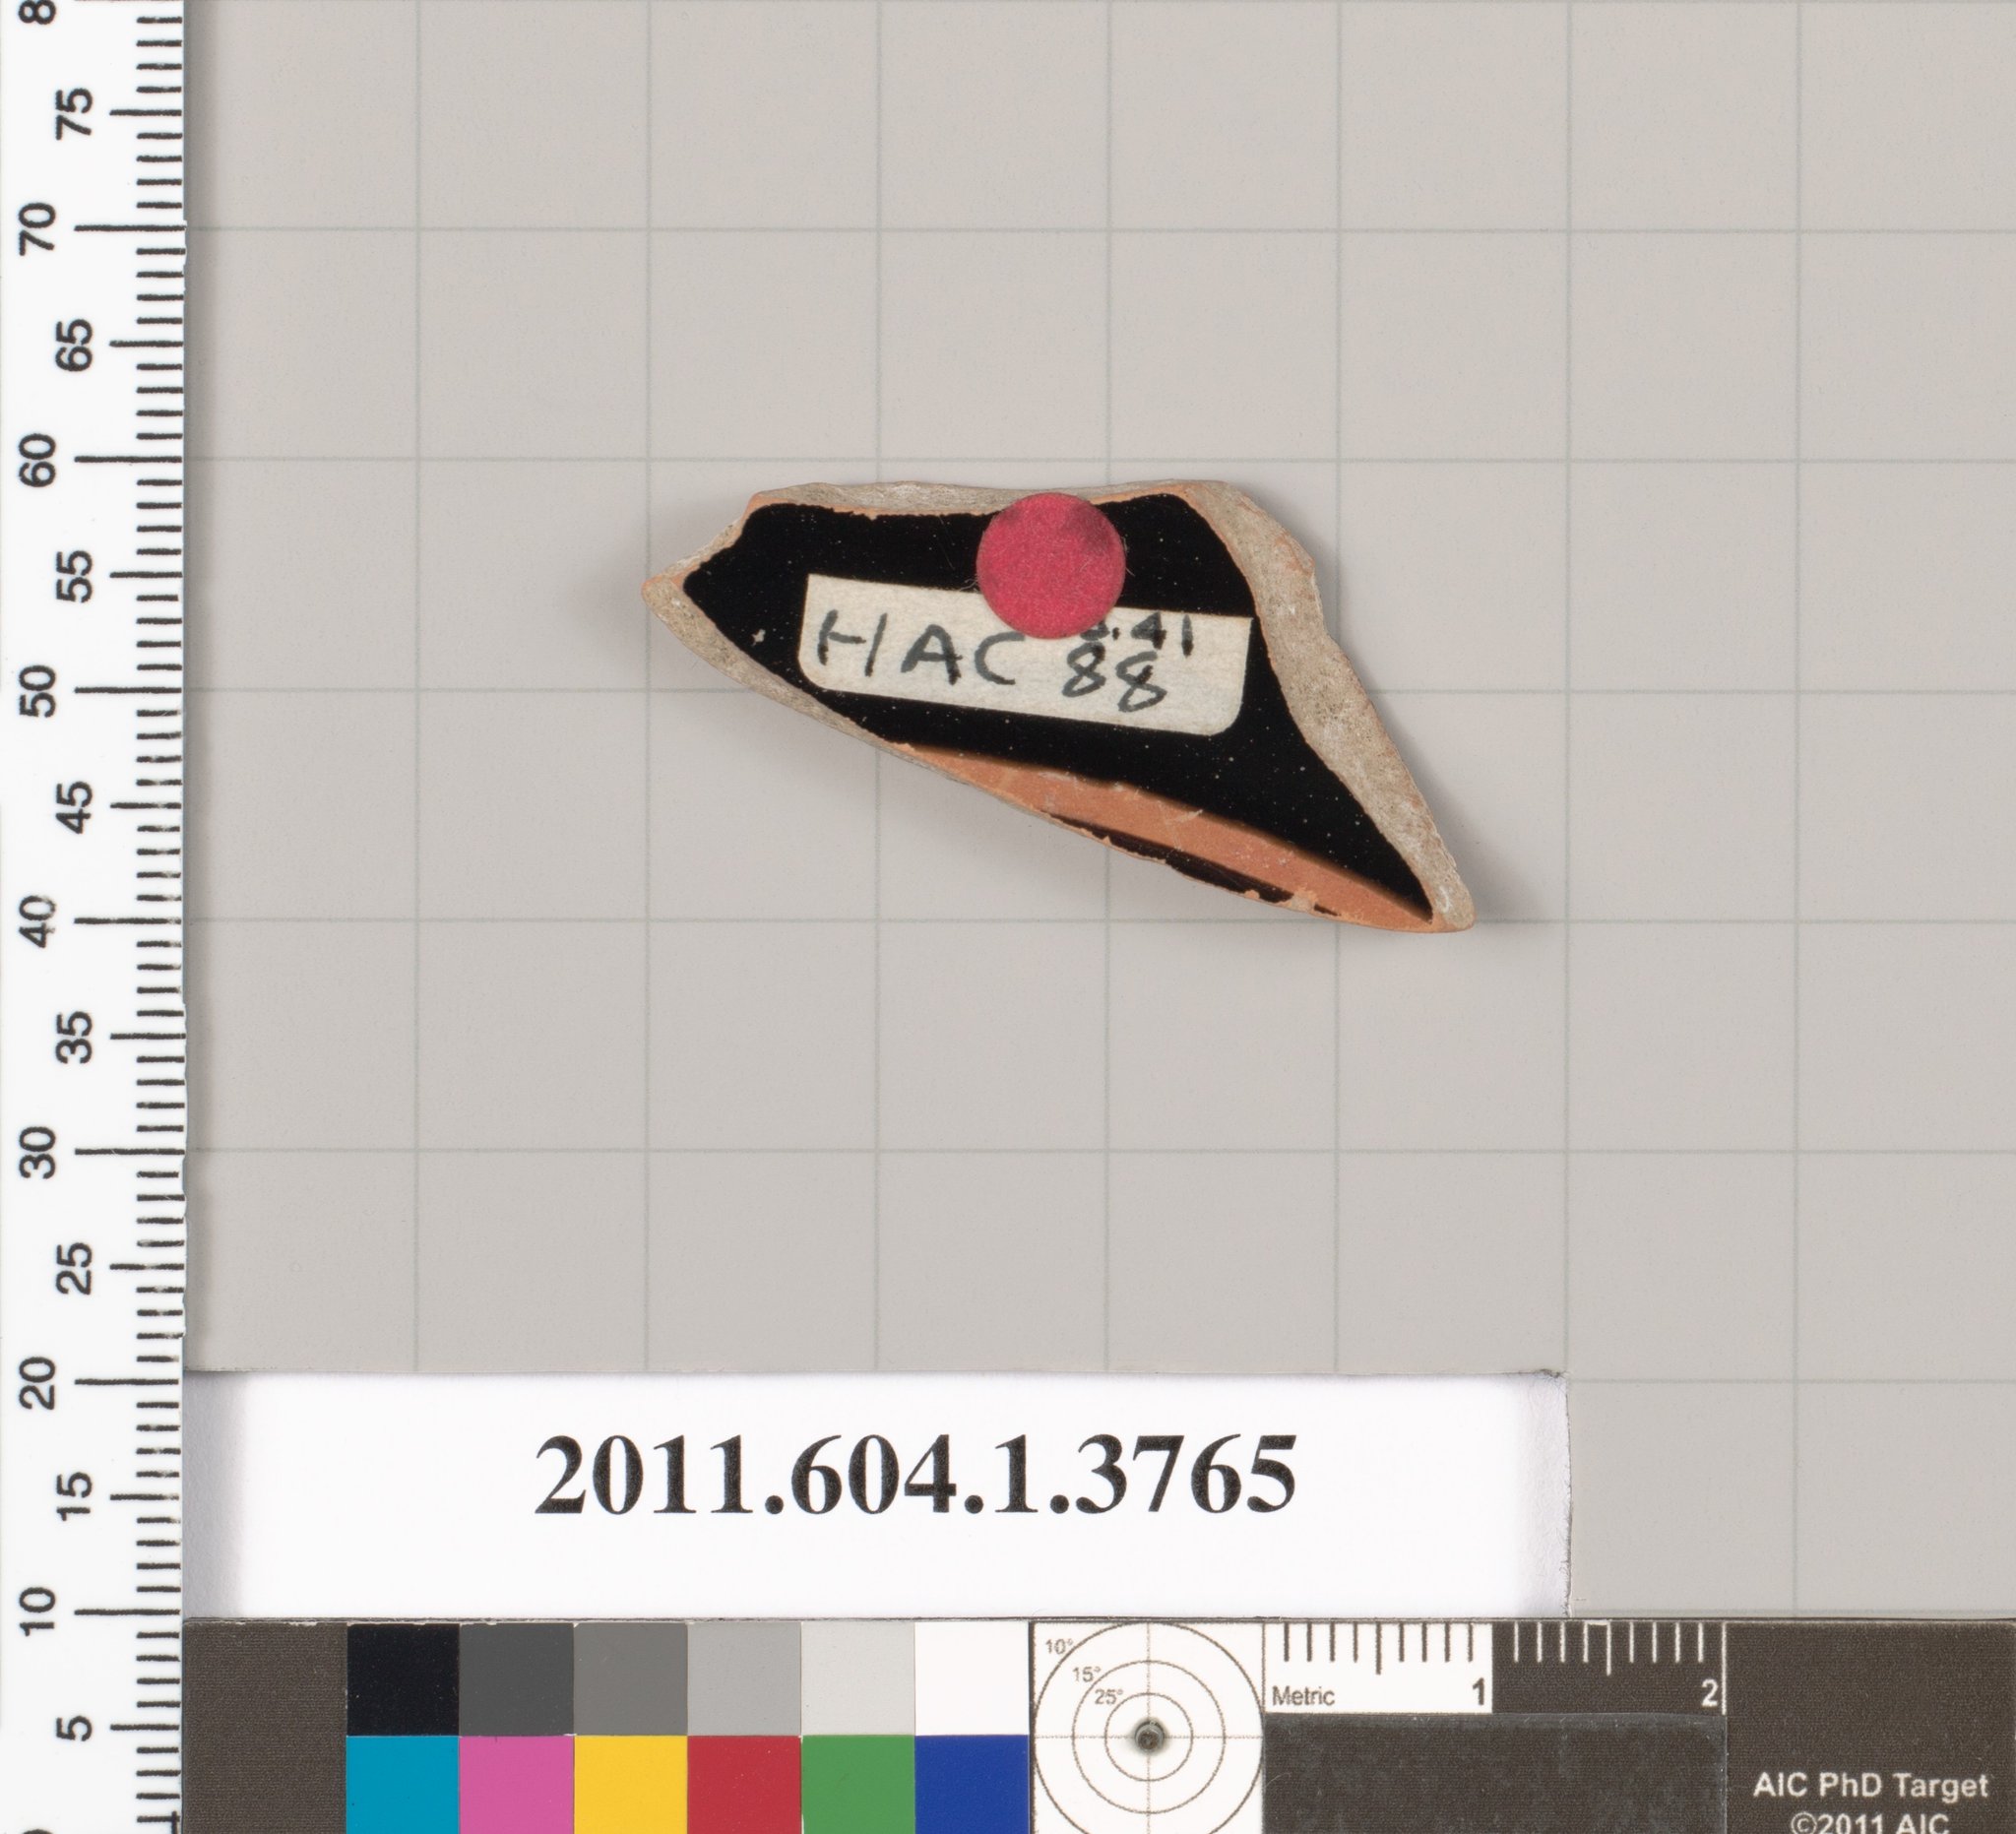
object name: kylix fragment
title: Terracotta fragment of a kylix (drinking cup)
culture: greek, attic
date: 475-451 BCE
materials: terracotta